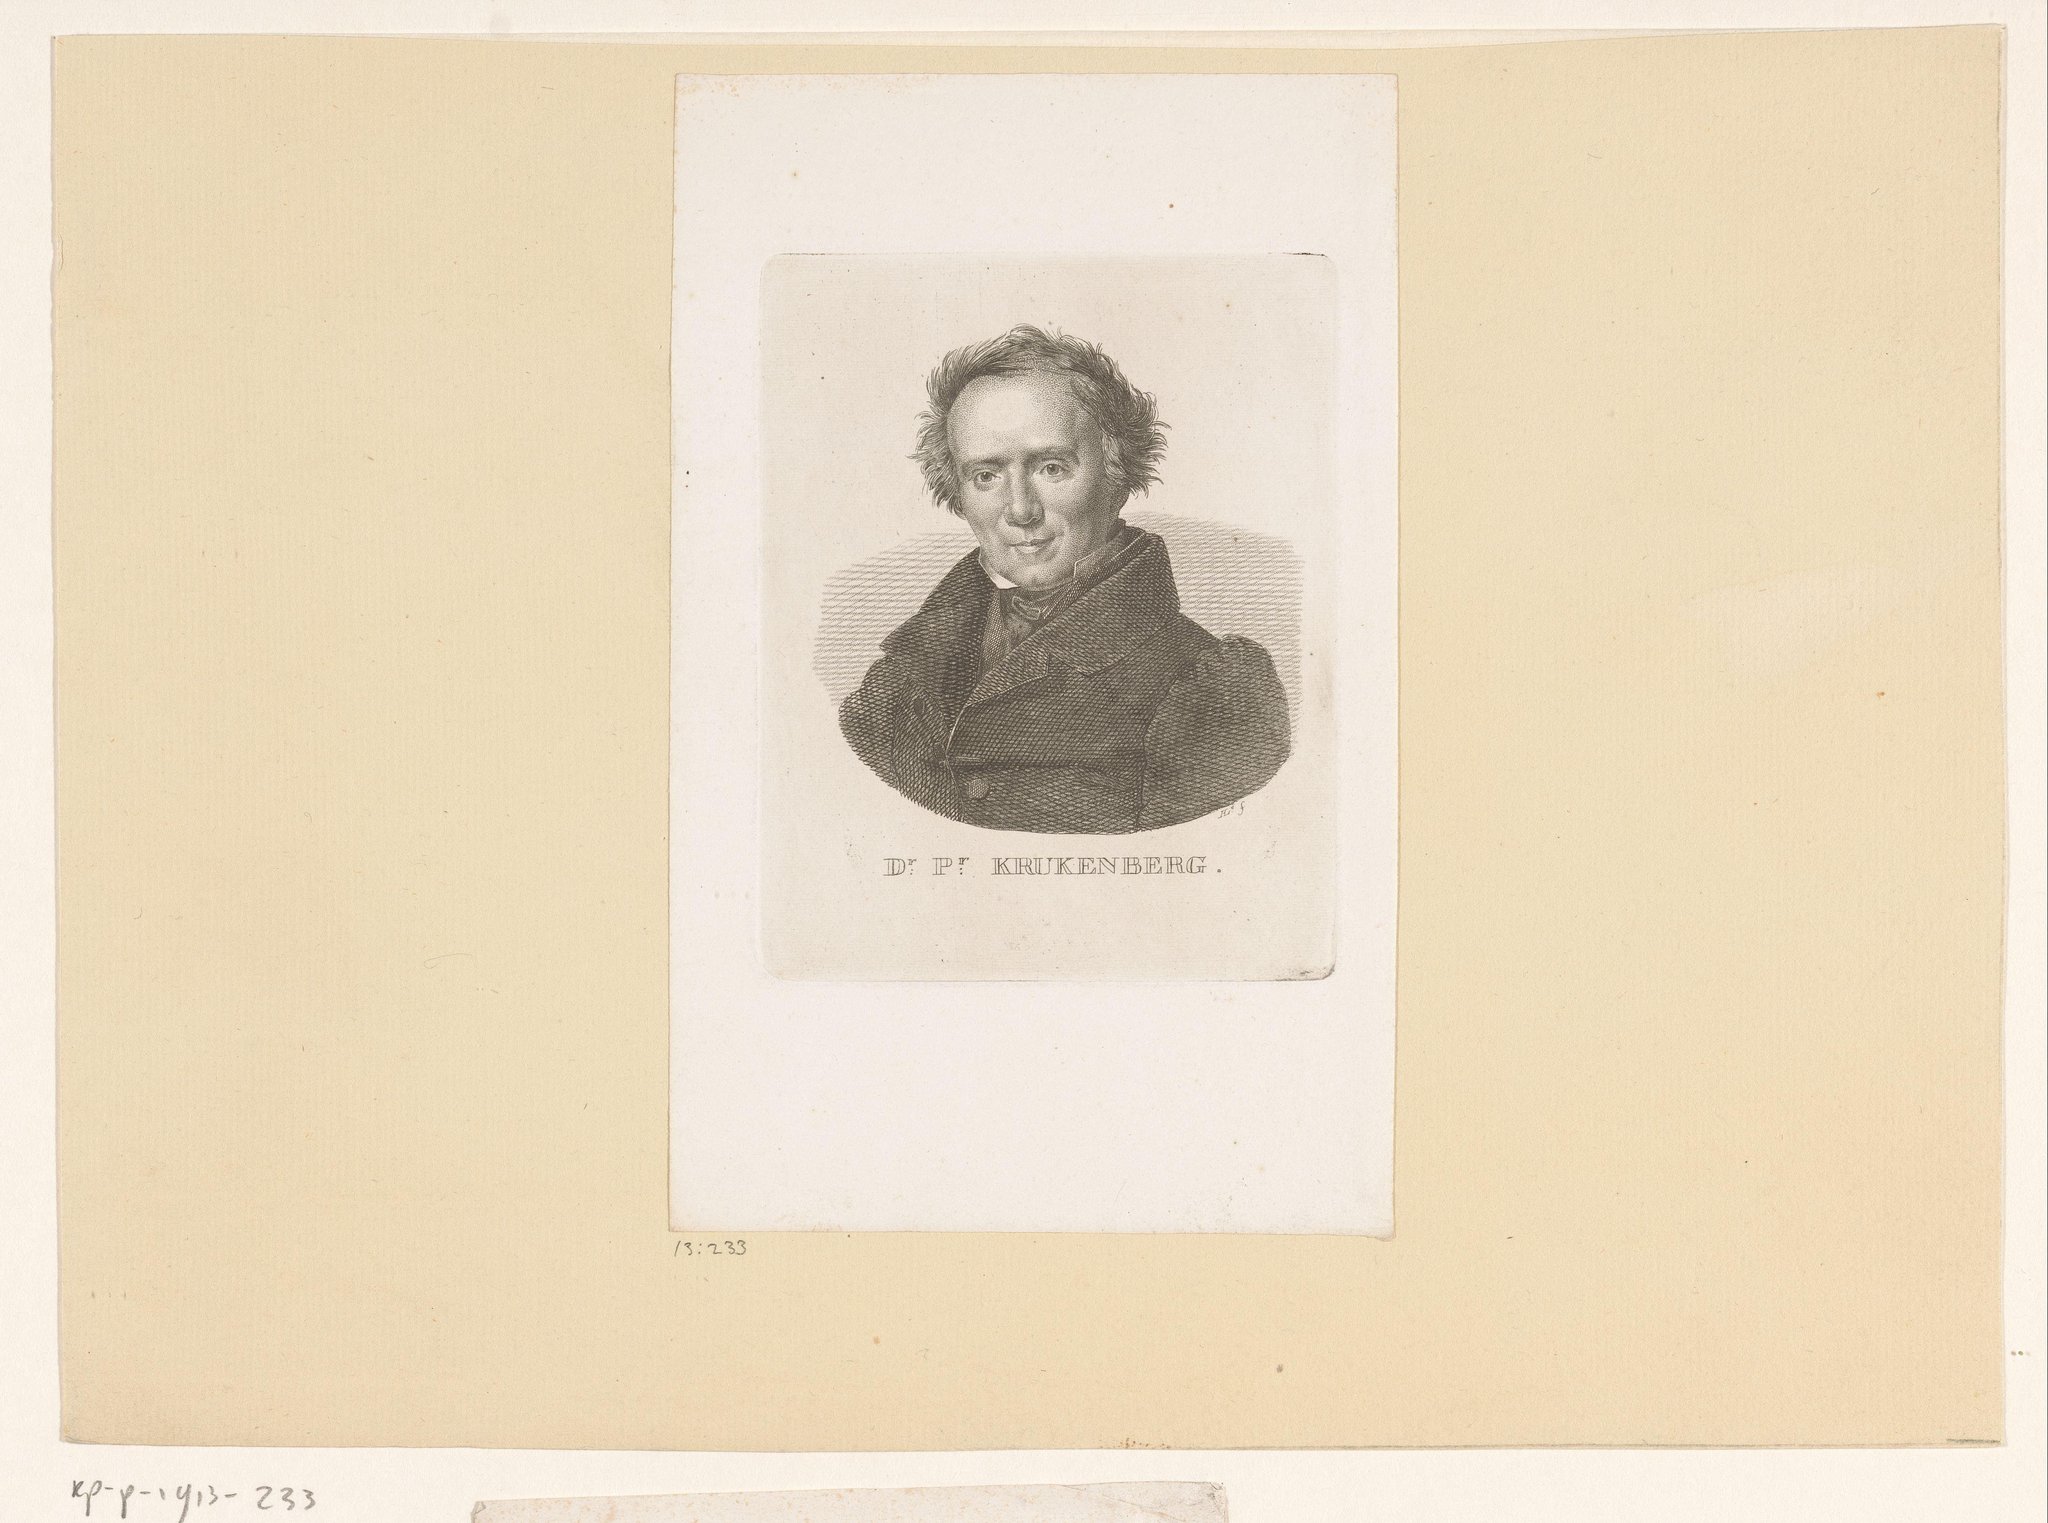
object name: print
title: Portret van Peter Krukenberg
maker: heinrich lödel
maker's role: print maker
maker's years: 1798-1861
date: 1808-1861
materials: paper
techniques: engraving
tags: historical persons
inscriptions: collector's mark: Lugt 2228